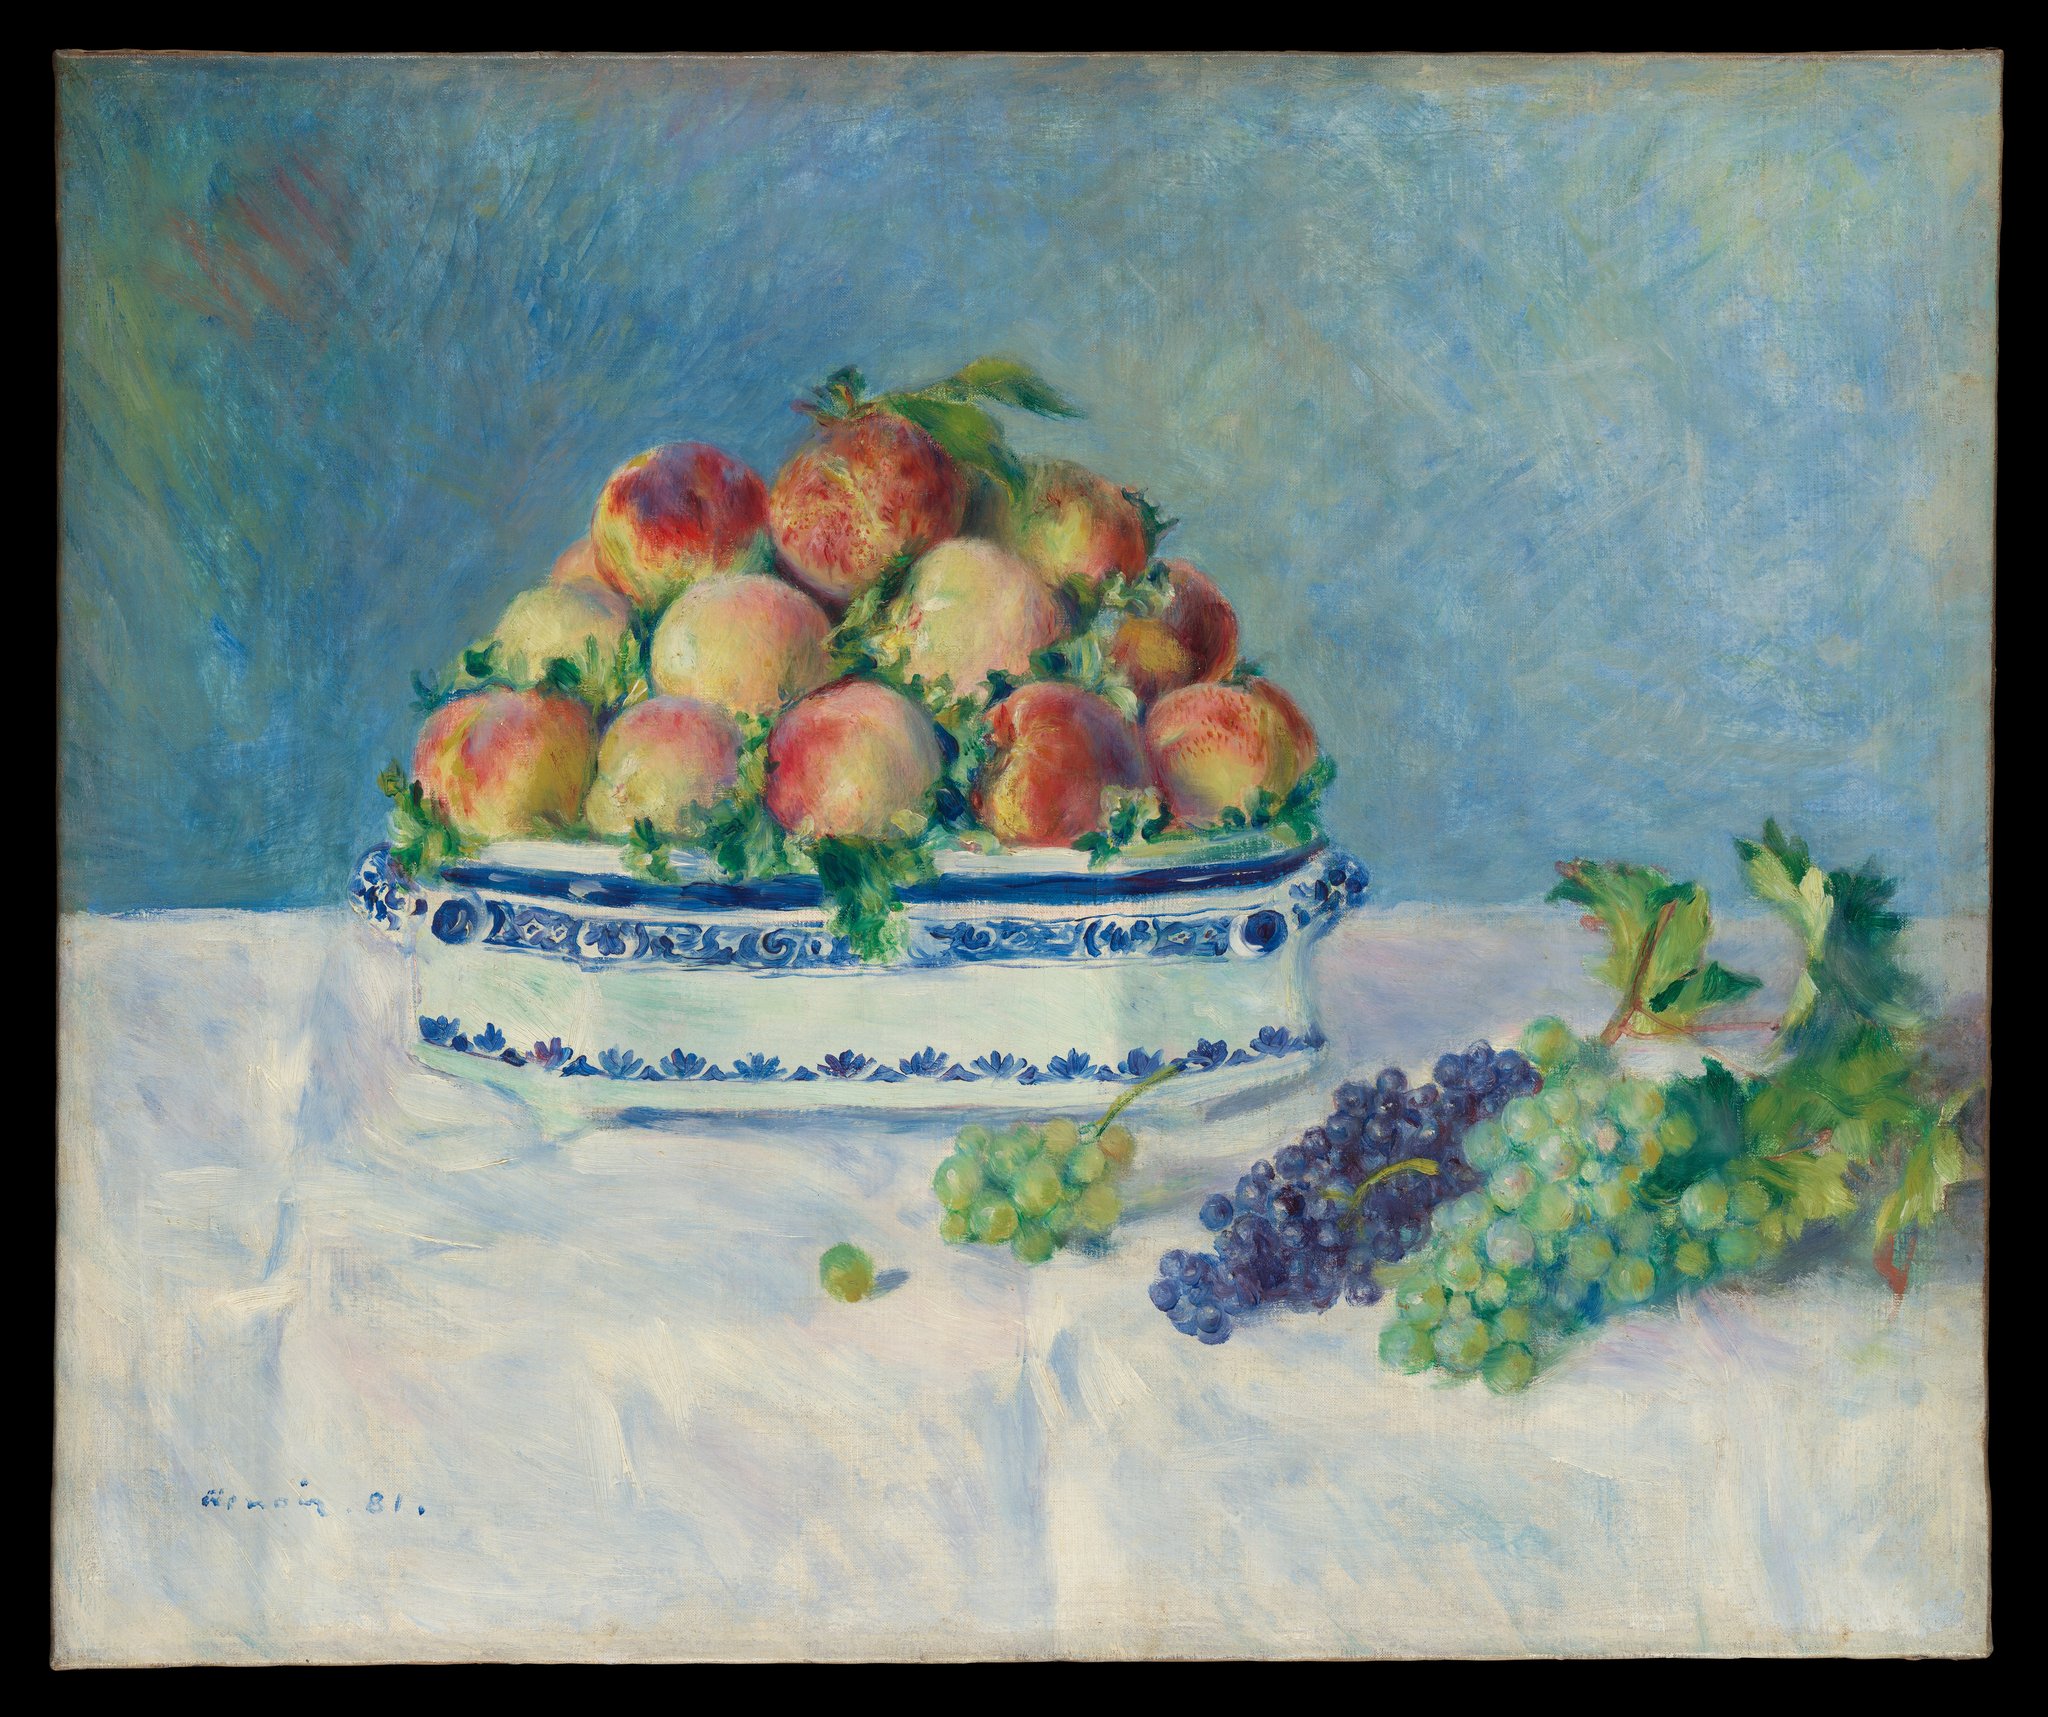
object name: painting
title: Still Life with Peaches and Grapes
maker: pierre auguste renoir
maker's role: artist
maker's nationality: french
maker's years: 1841-1919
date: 1881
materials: canvas, oil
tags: grapes,peaches,still life